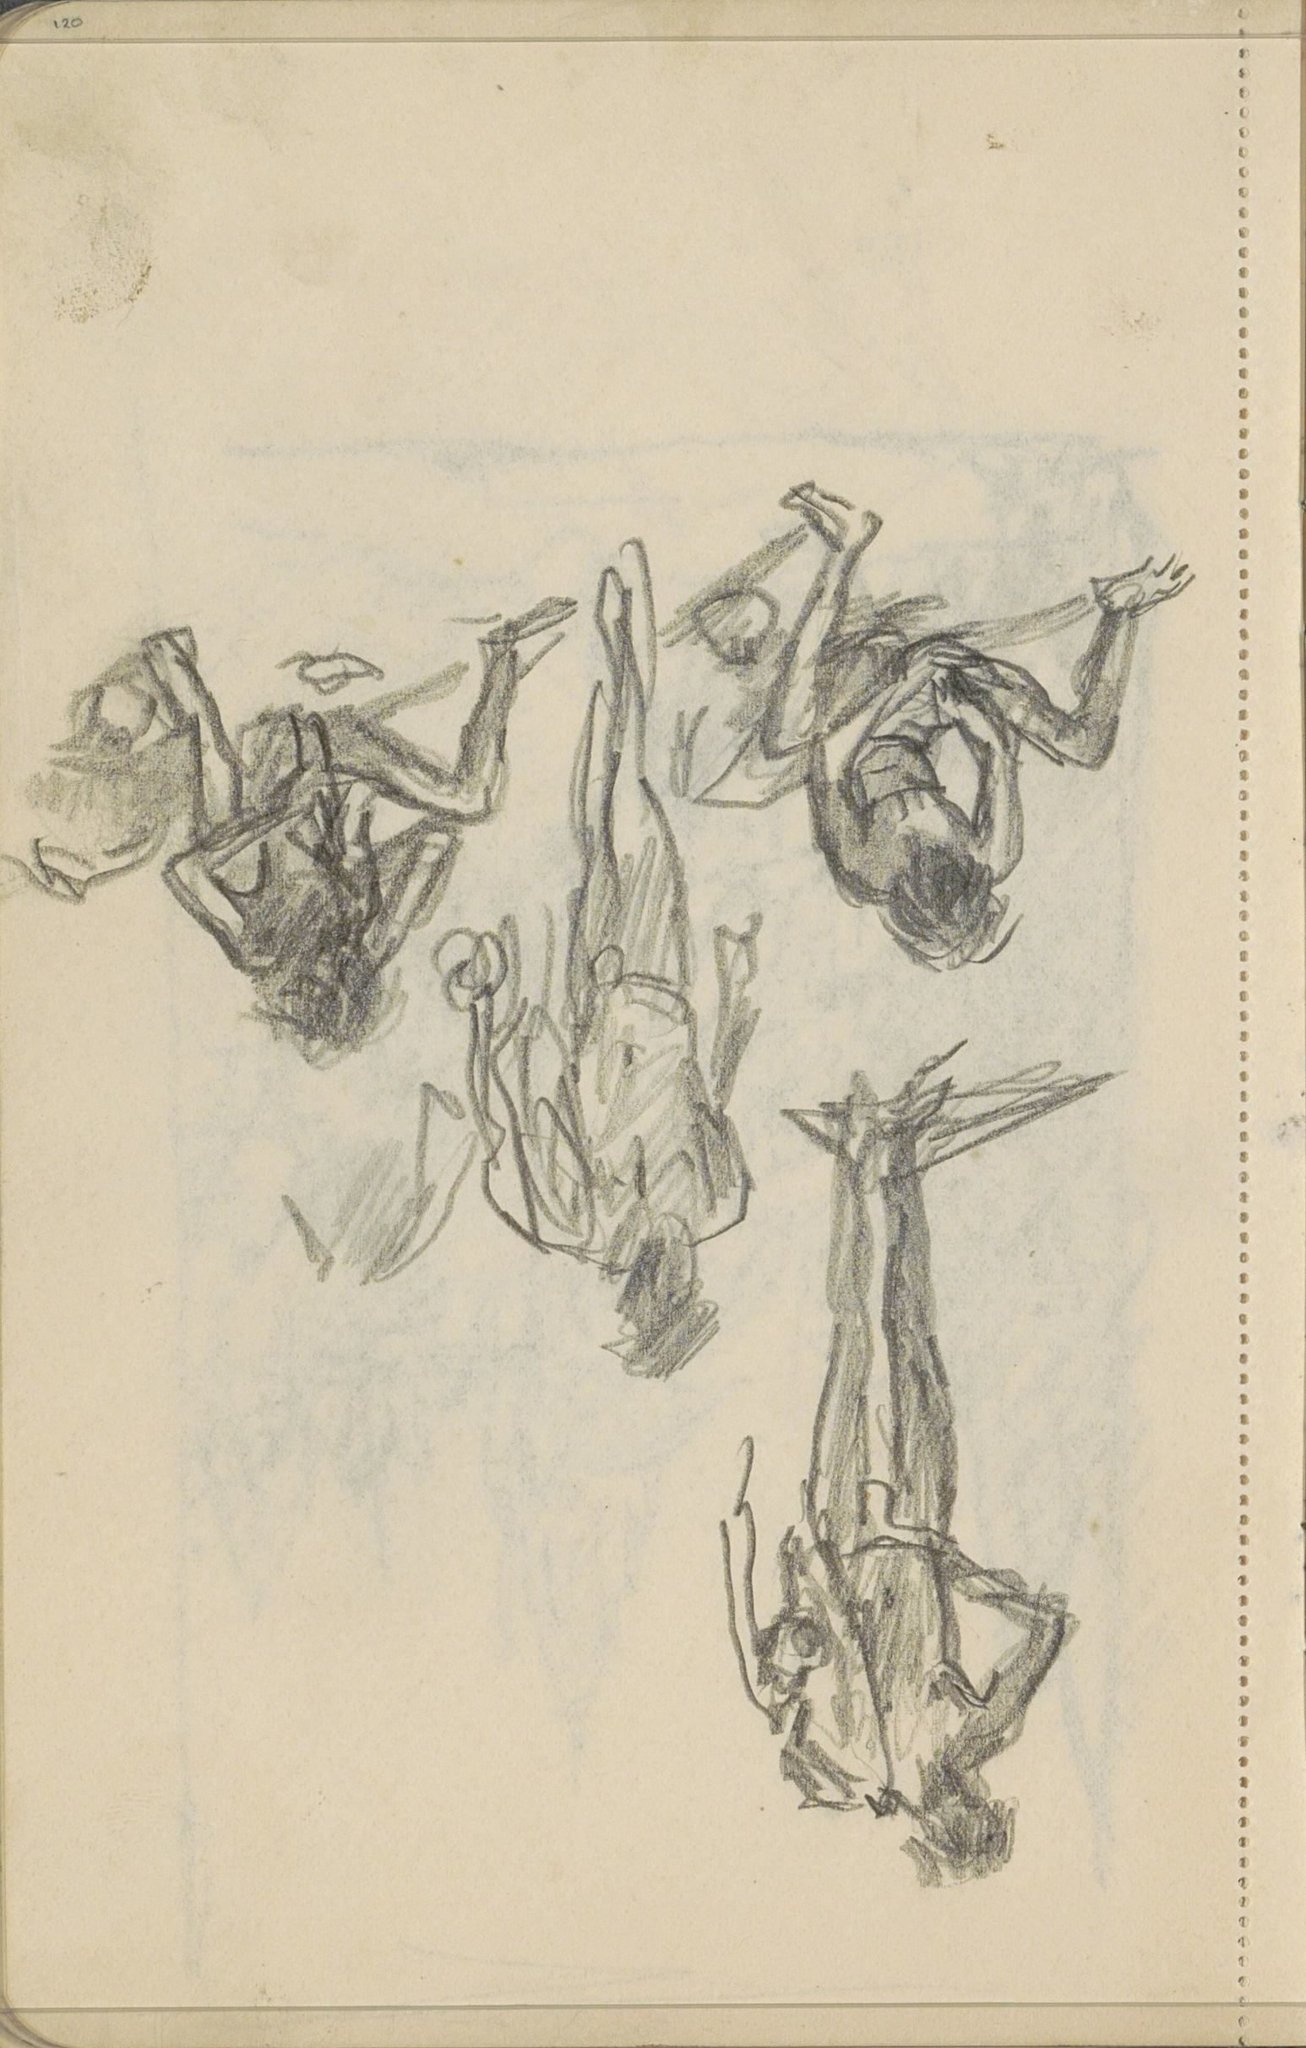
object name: sketchbook leaf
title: Staande en zittende Indiërs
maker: marius bauer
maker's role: draughtsman, print maker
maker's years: 1867-1932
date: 1924-1925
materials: paper, pencil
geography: india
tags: standing figure, sitting figure, asiatic races and peoples: indians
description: De zittende figuren zijn vermoedelijk aan het werk. Pagina 120 uit een schetsboek met 87 bladen.